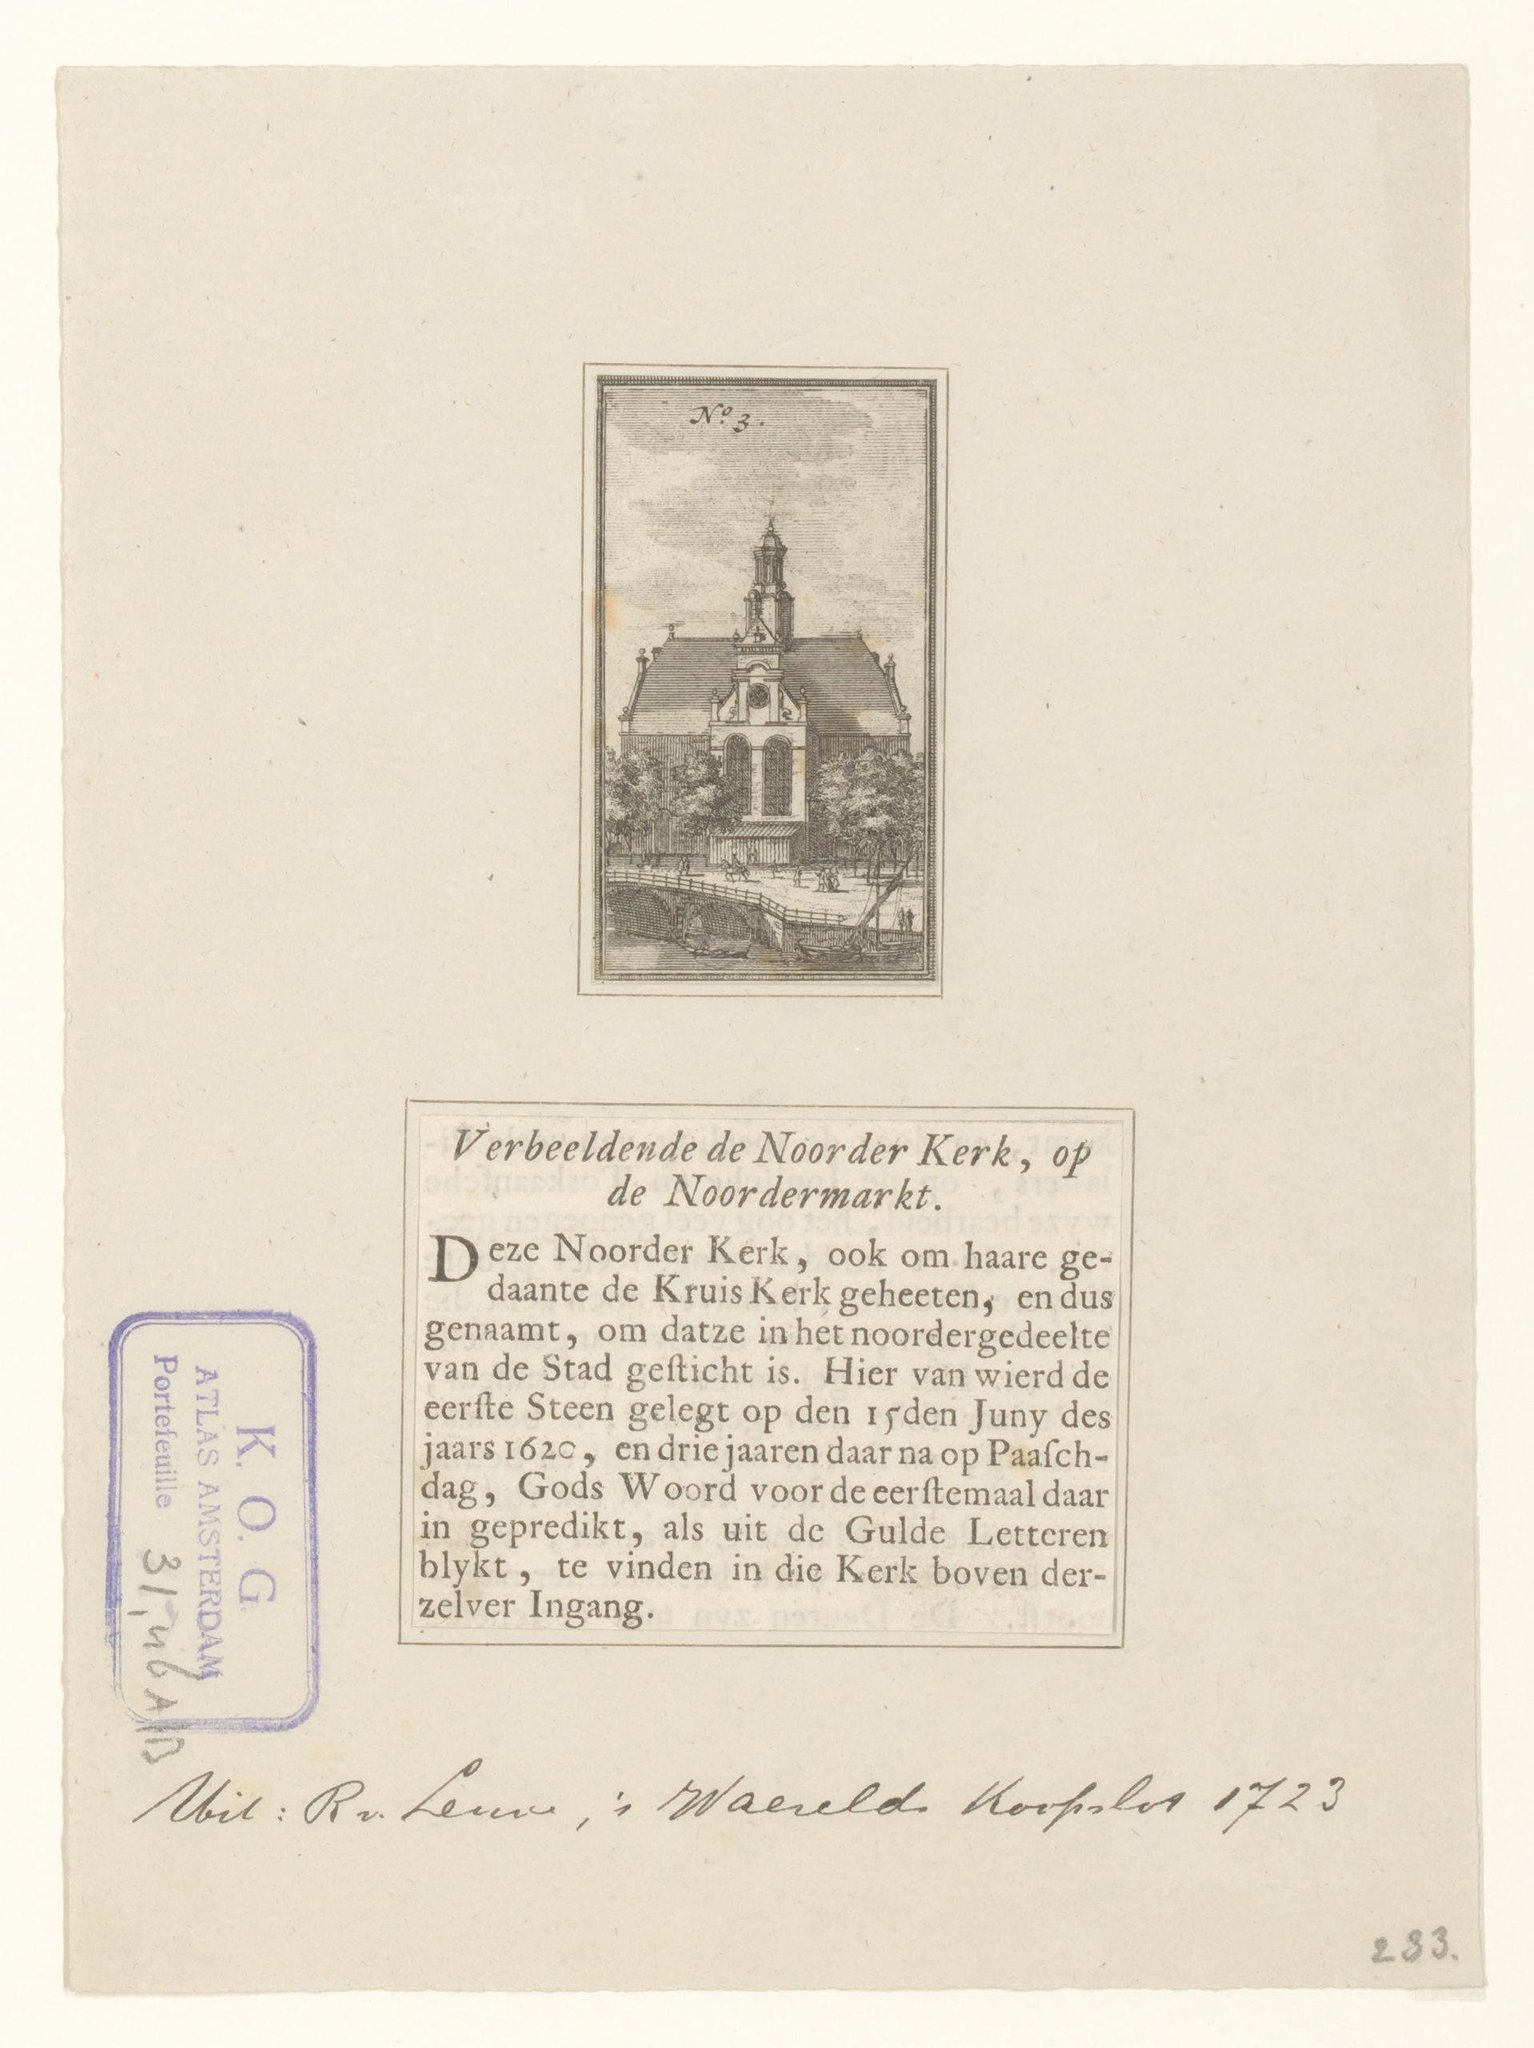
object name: book illustration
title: Gezicht op de Noorderkerk te Amsterdam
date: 1736-1744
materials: paper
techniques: etching, letterpress printing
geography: haarlem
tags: bridge in city across river, canal, etc. (+ city(-scape) with figures, staffage), church (exterior)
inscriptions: collector's mark: Lugt 1641b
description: Centraal bovenaan genummerd: No. 3. Onder de prent is een verklarend bijschrift van de prent geplakt. Onderwerpsrubriek binnen de Atlas Amsterdam: Kerkwezen: Hervormde Gemeente: Noorderkerk.